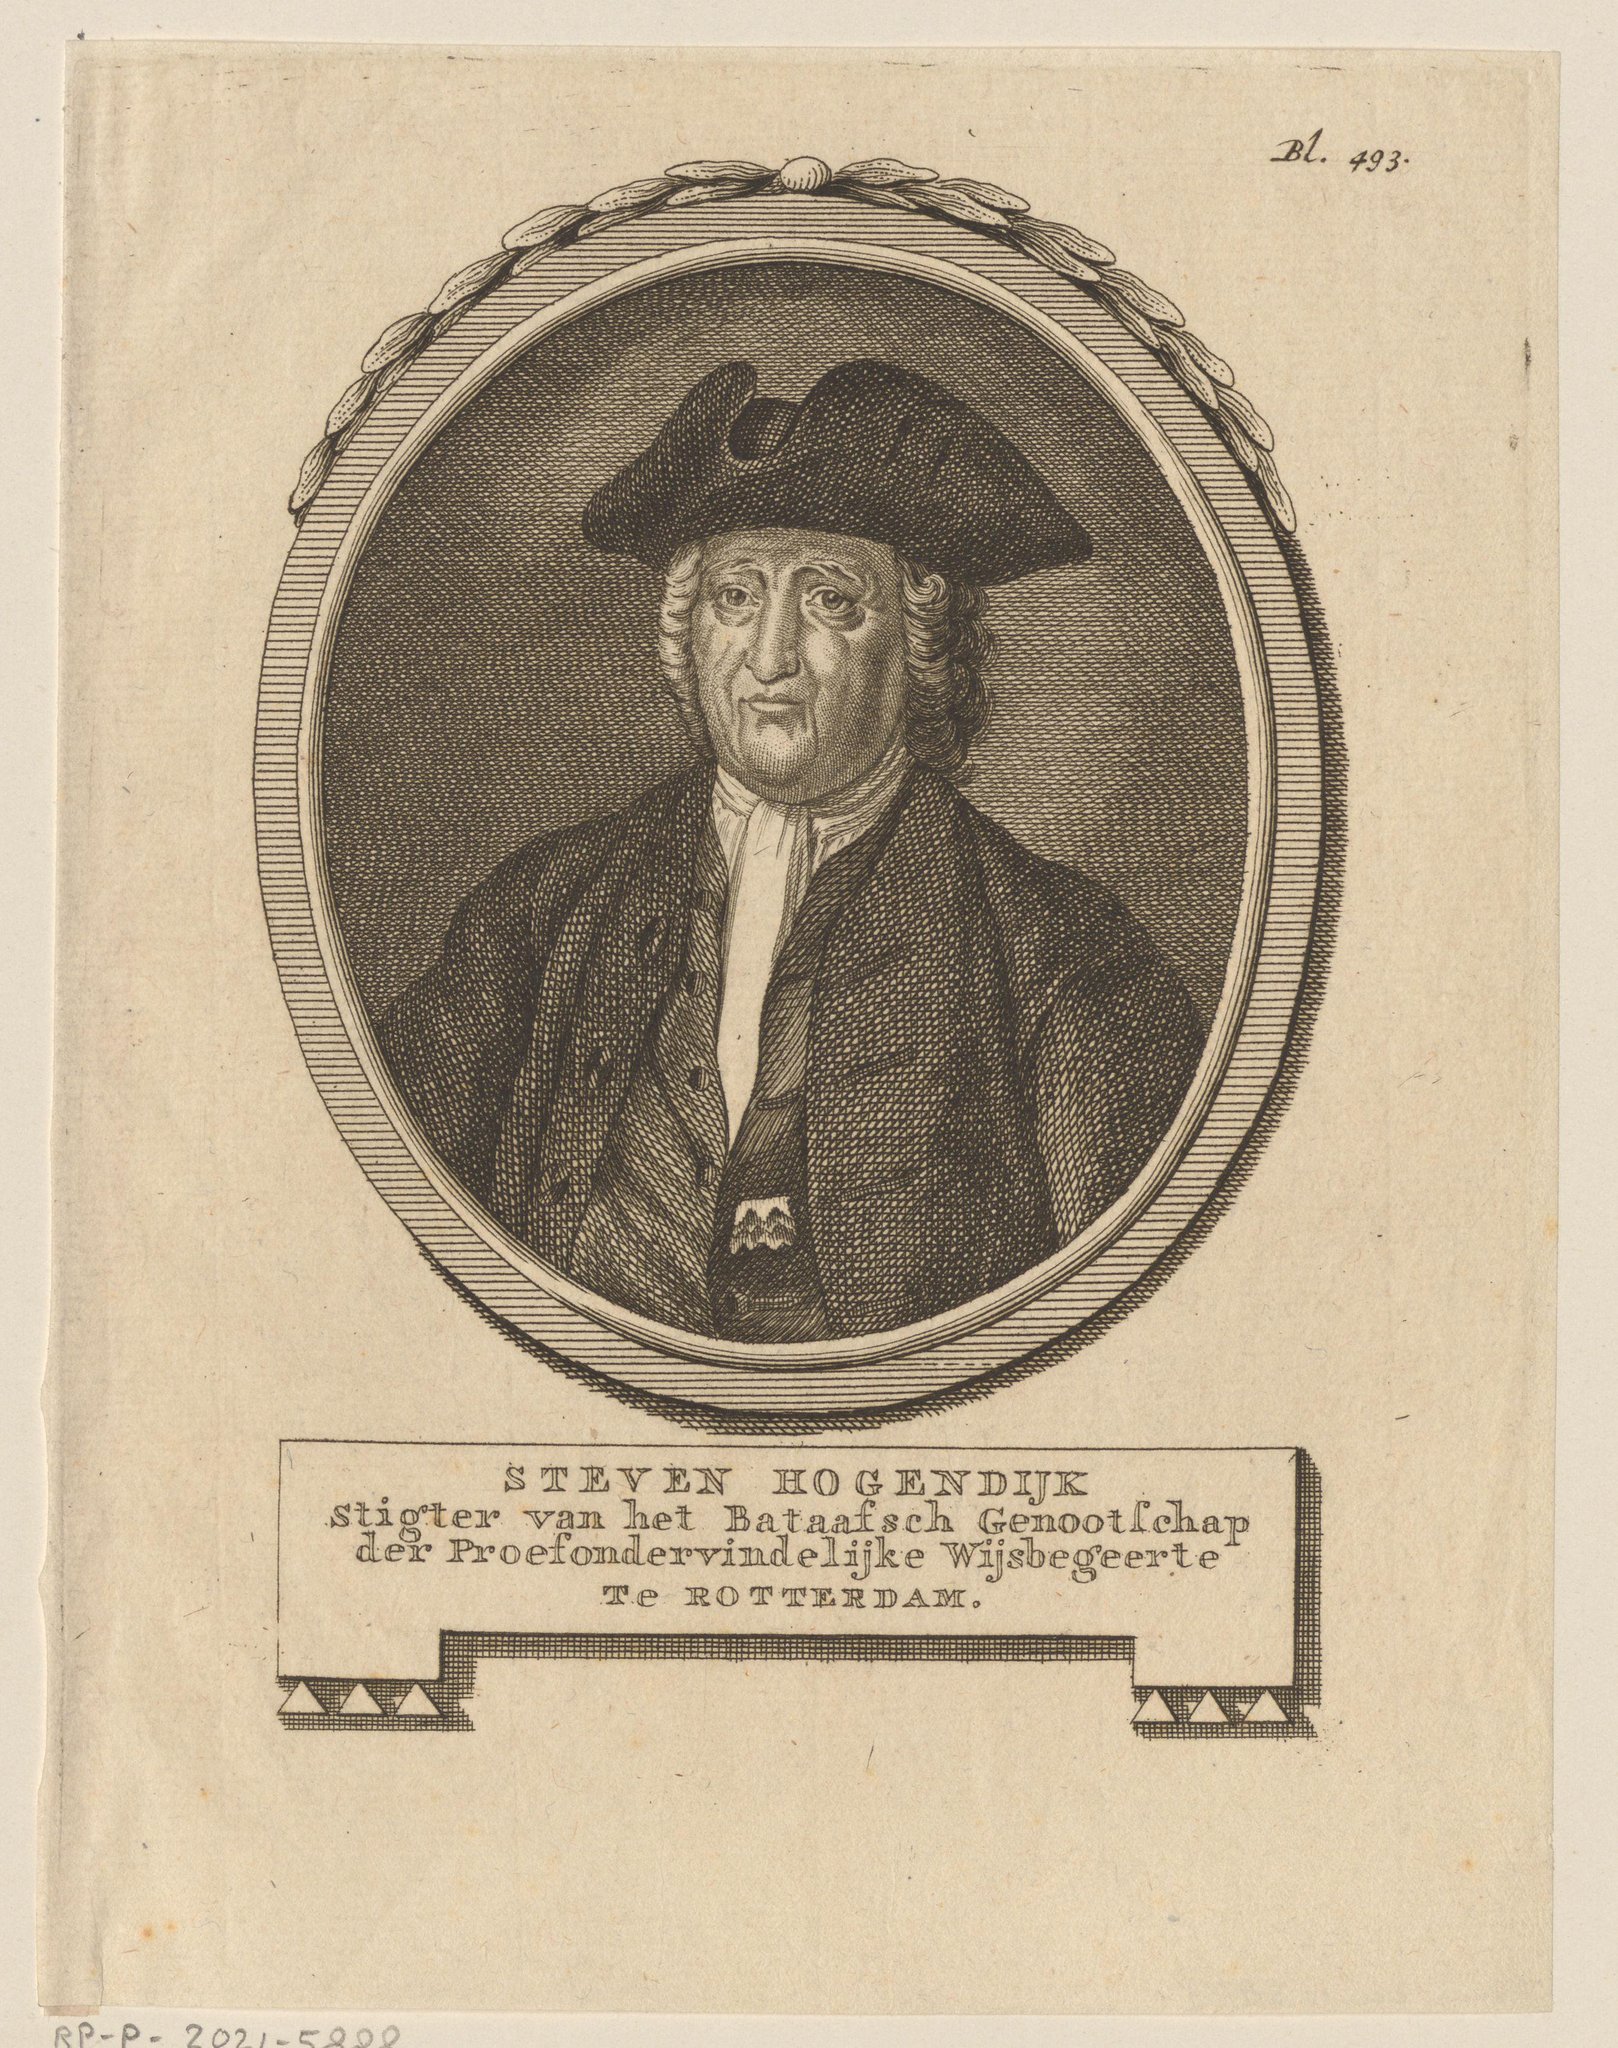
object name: book illustration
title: Portret van Steven Hoogendijk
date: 1800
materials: paper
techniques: engraving, etching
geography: amsterdam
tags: rotterdam, physicist, instrument maker, historical persons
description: Prent uit: Staatkundige historie van Holland (...) benevens de maandelyksche Nederlandsche Mercurius. Amsterdam: Jan Augustijn Swalm, 1800, dl. 80.